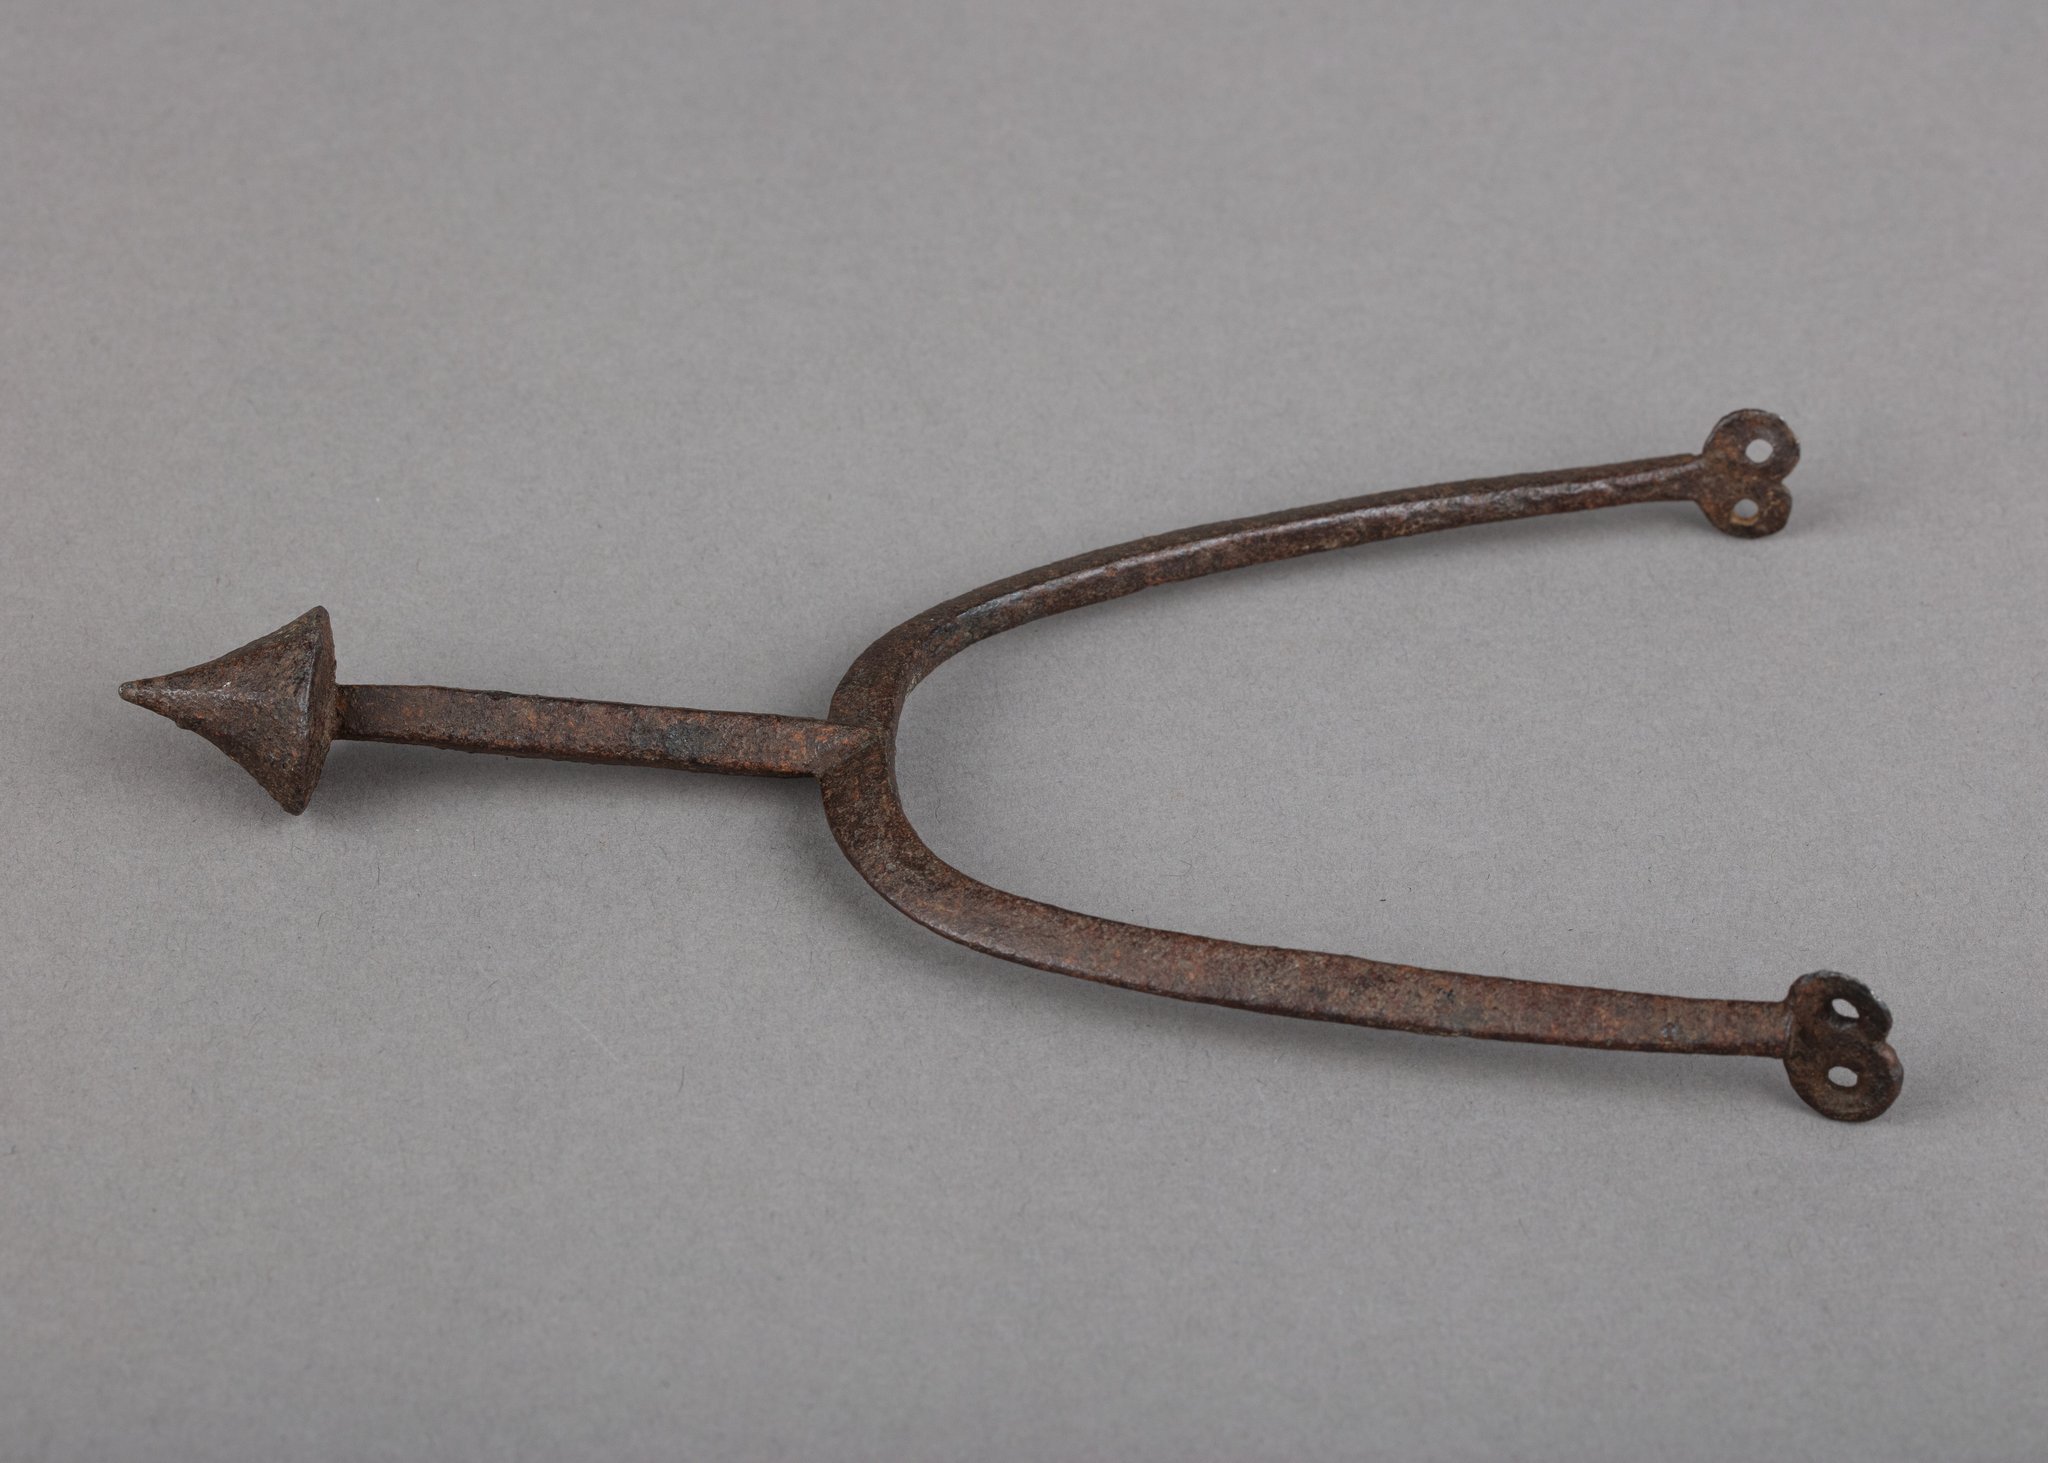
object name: spur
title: Prick Spur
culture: european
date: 1001-1100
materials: metal alloy